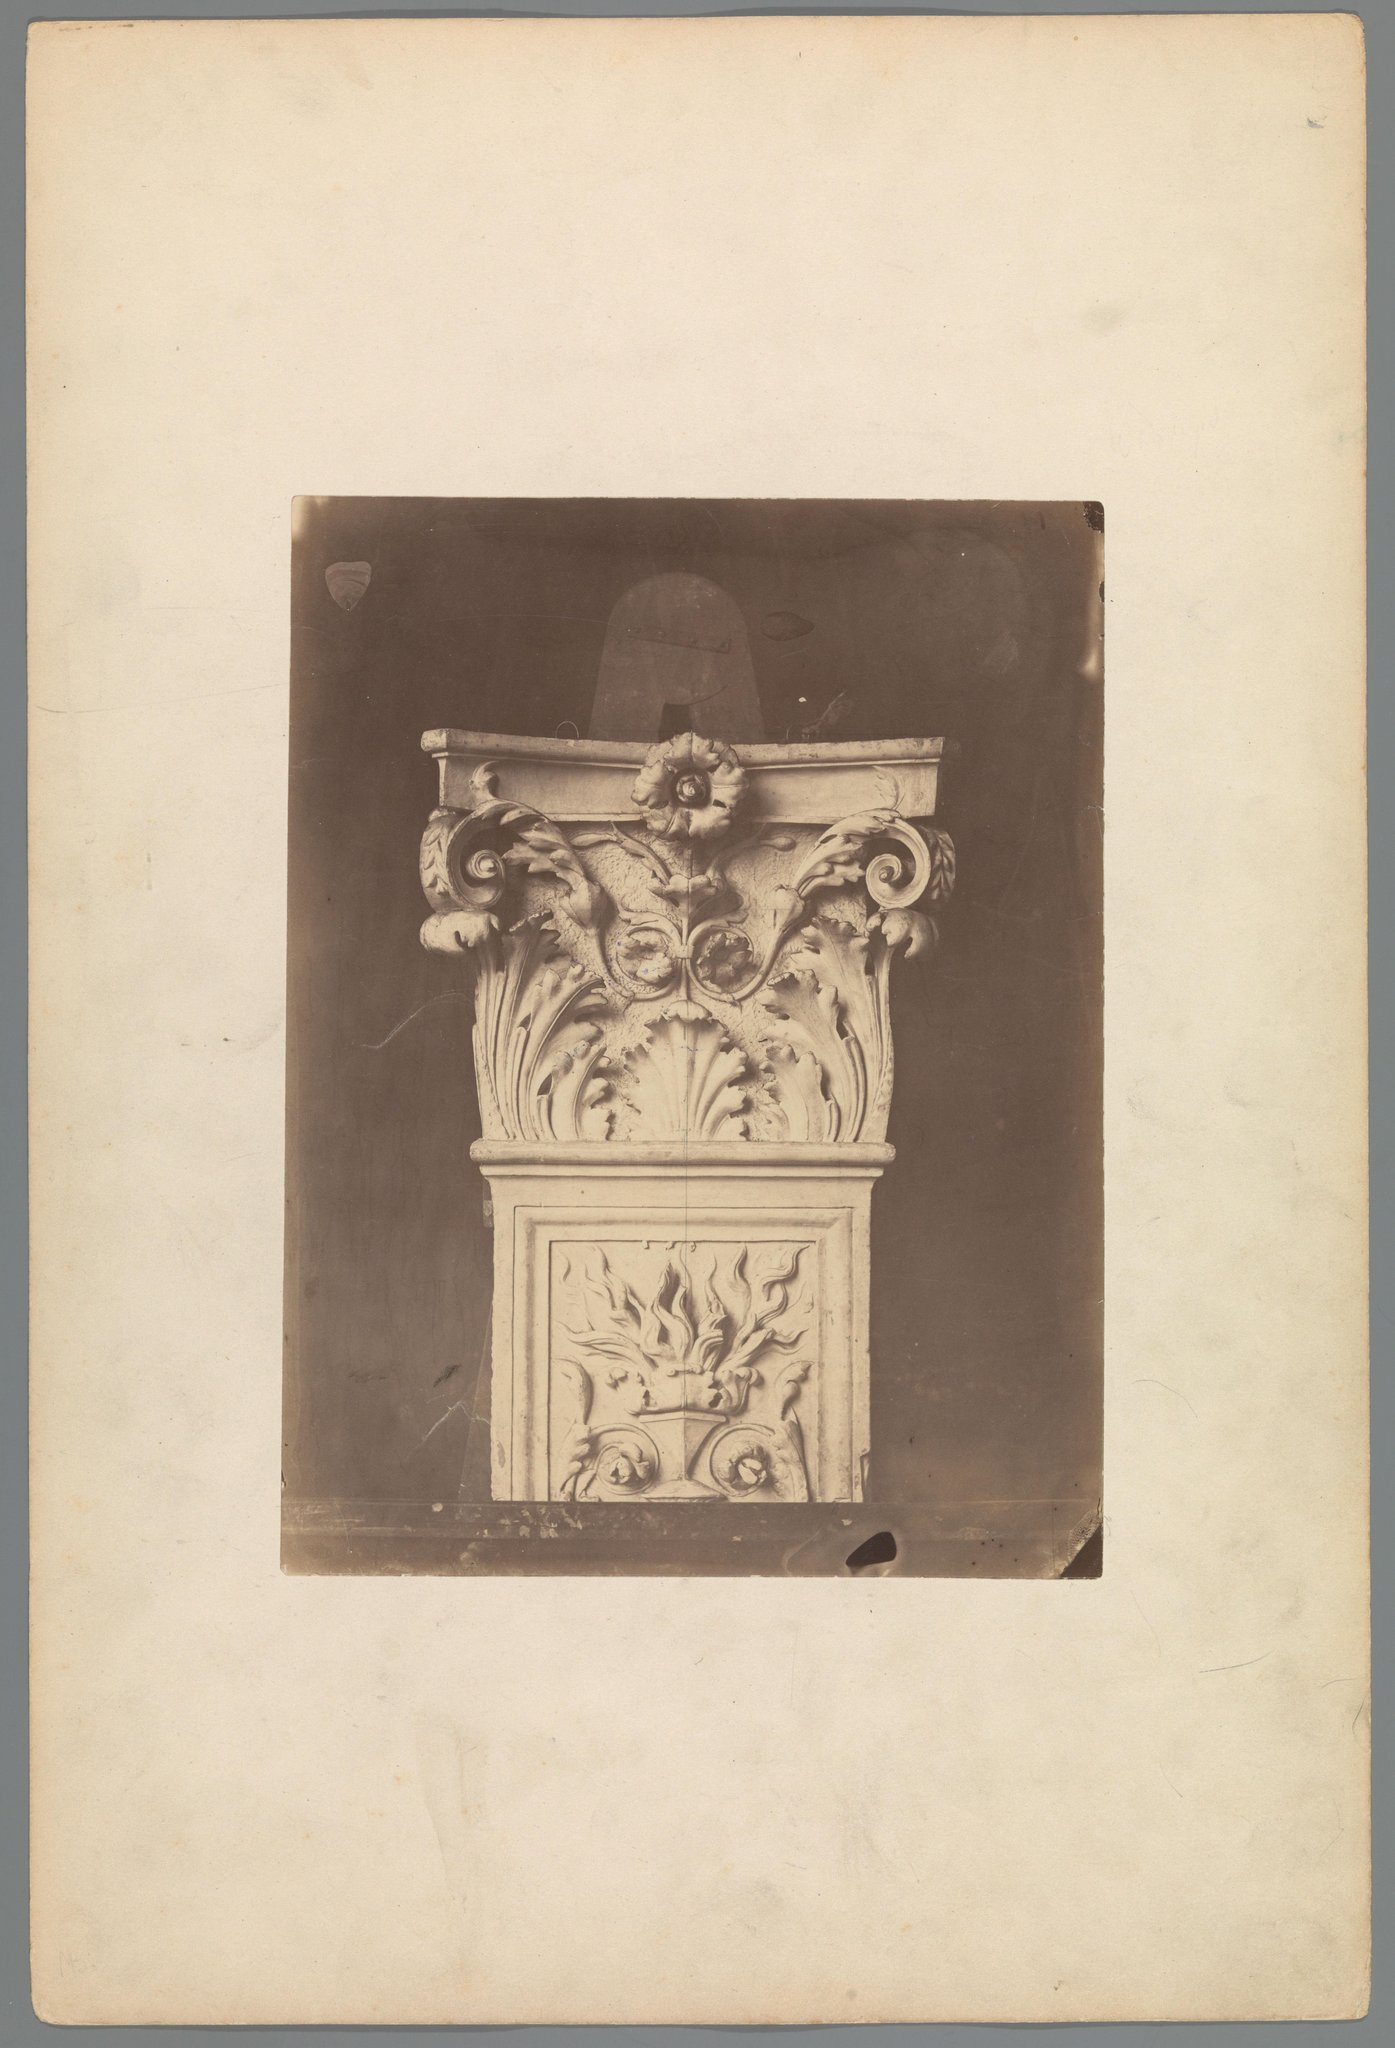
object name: photograph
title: Kapiteel van een zuil met acanthusbladeren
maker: Anonymous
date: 1875-1900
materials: cardboard, photographic support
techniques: albumen print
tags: acanthus ~ ornament, capital (~ column, pillar), sculpture (+ relief ~ sculpture)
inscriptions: collector's mark: Lugt 3937